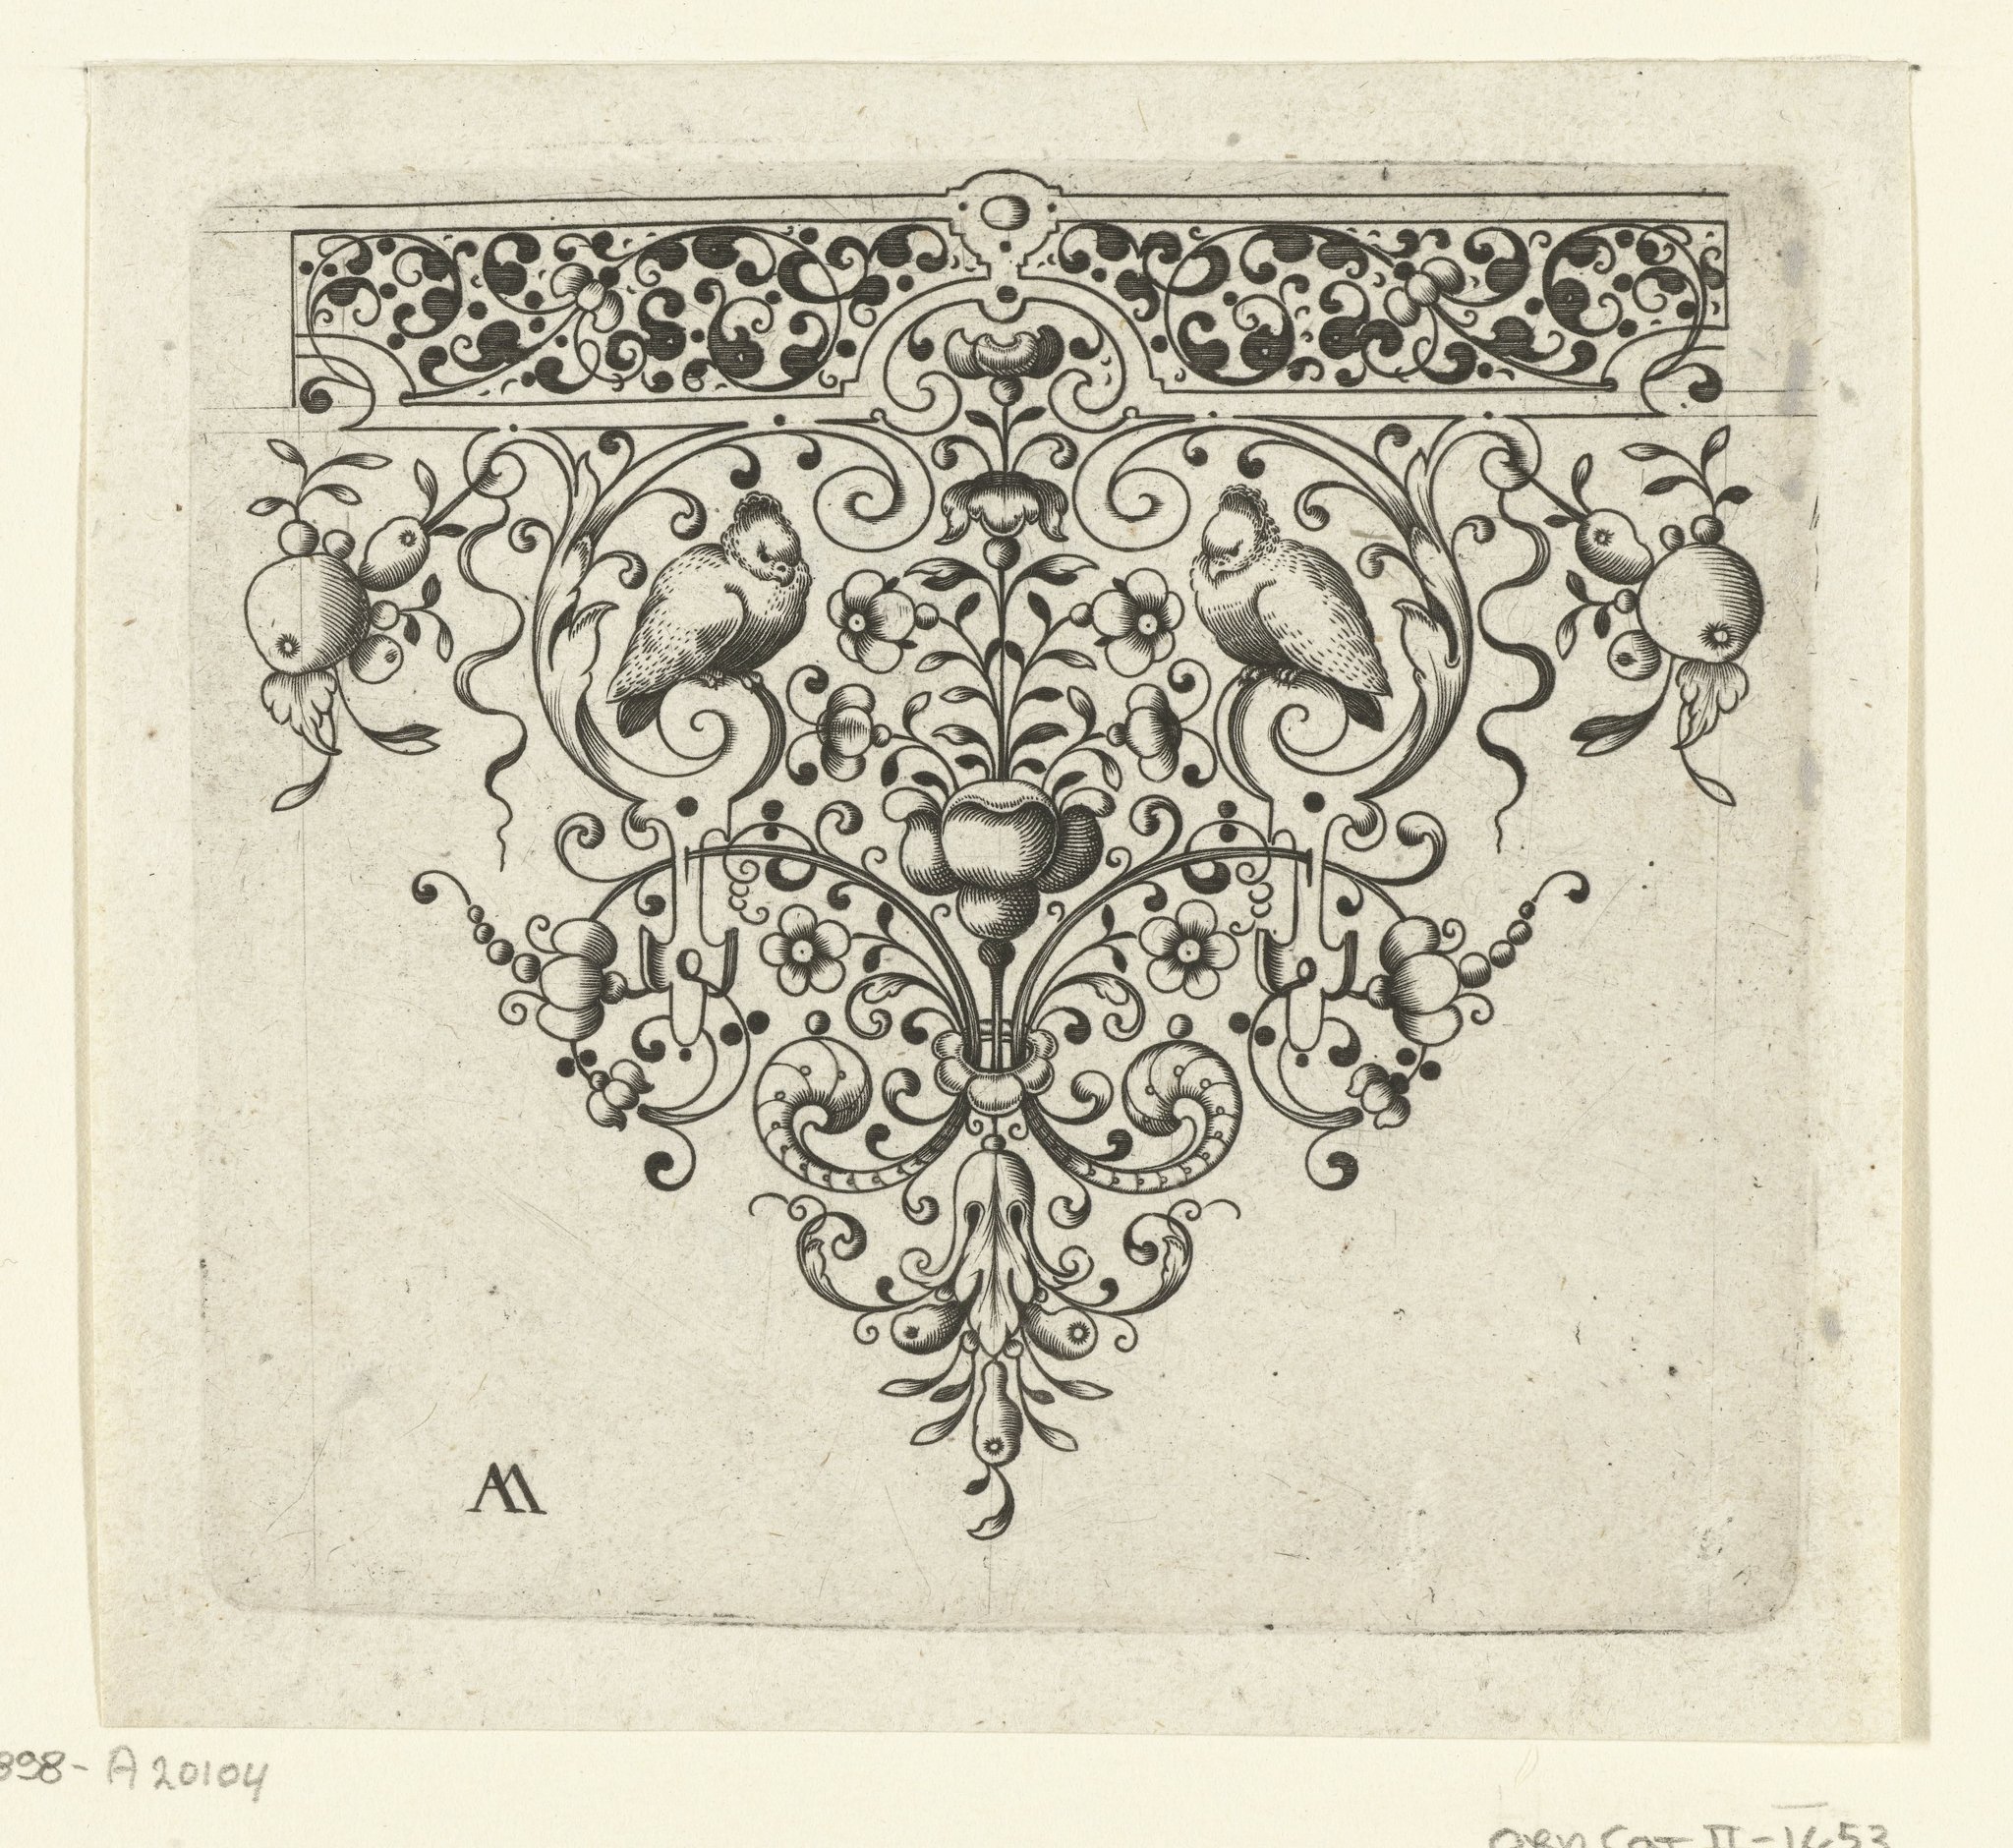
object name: print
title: Spits met bloem en twee vogels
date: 1675-1700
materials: paper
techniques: engraving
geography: amsterdam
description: Bovenaan een rand van gestileerde ranken. Blad 3 uit serie van 6 bladen.